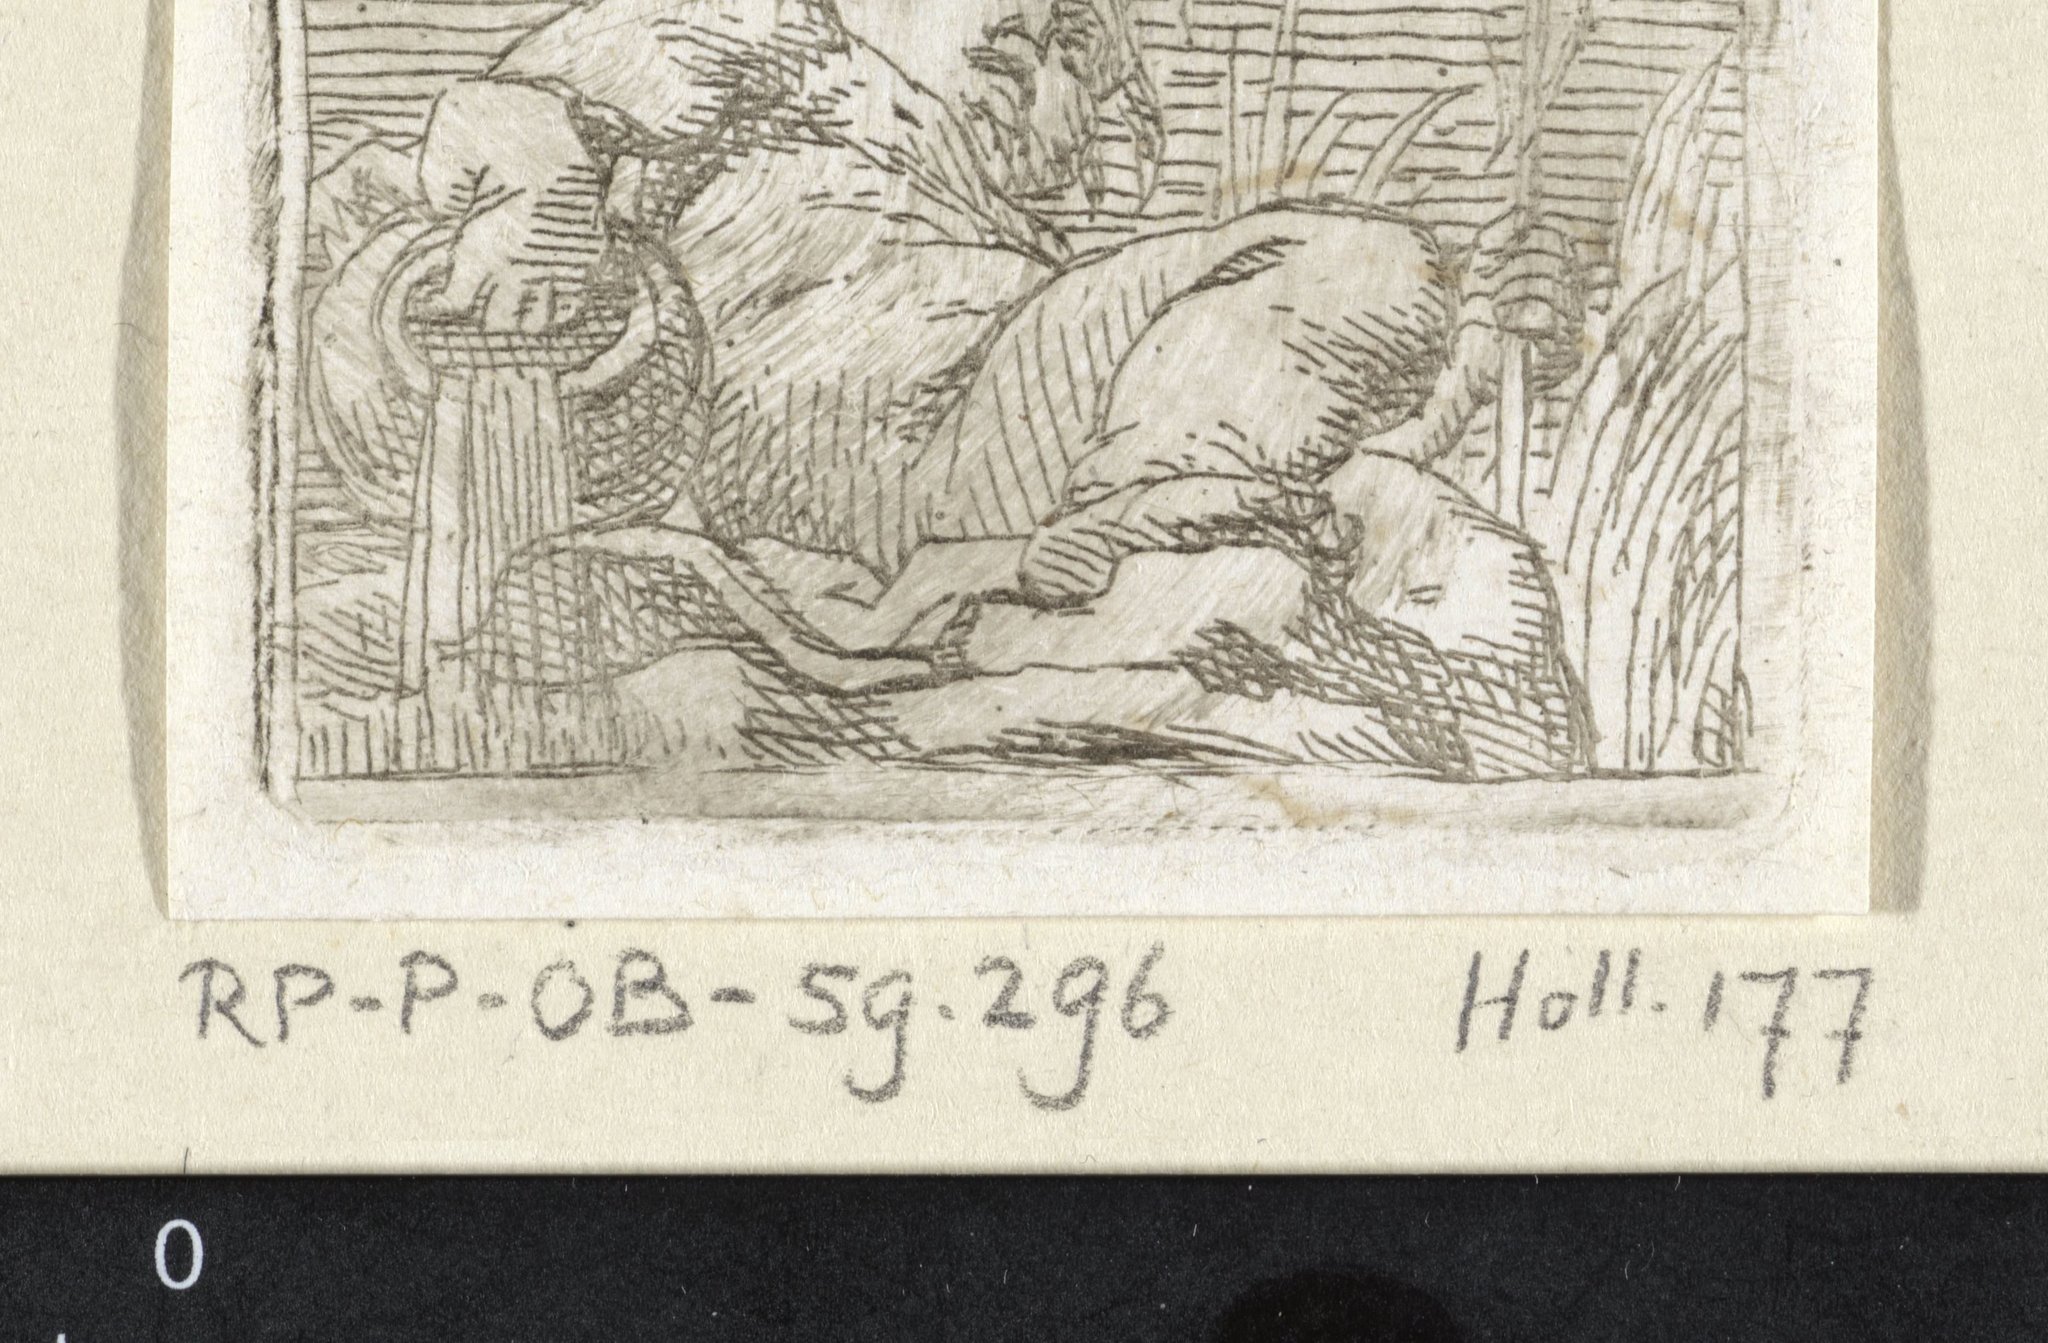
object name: print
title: Kind als riviergod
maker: cornelis schut (i)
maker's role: draughtsman, print maker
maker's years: 1597-1655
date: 1618-1655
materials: paper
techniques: etching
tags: child, river-gods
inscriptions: collector's mark: Lugt 240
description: Een liggend kind houdt in de ene hand een kruik vast, waaruit water stroomt, en in de andere hand een drietand.